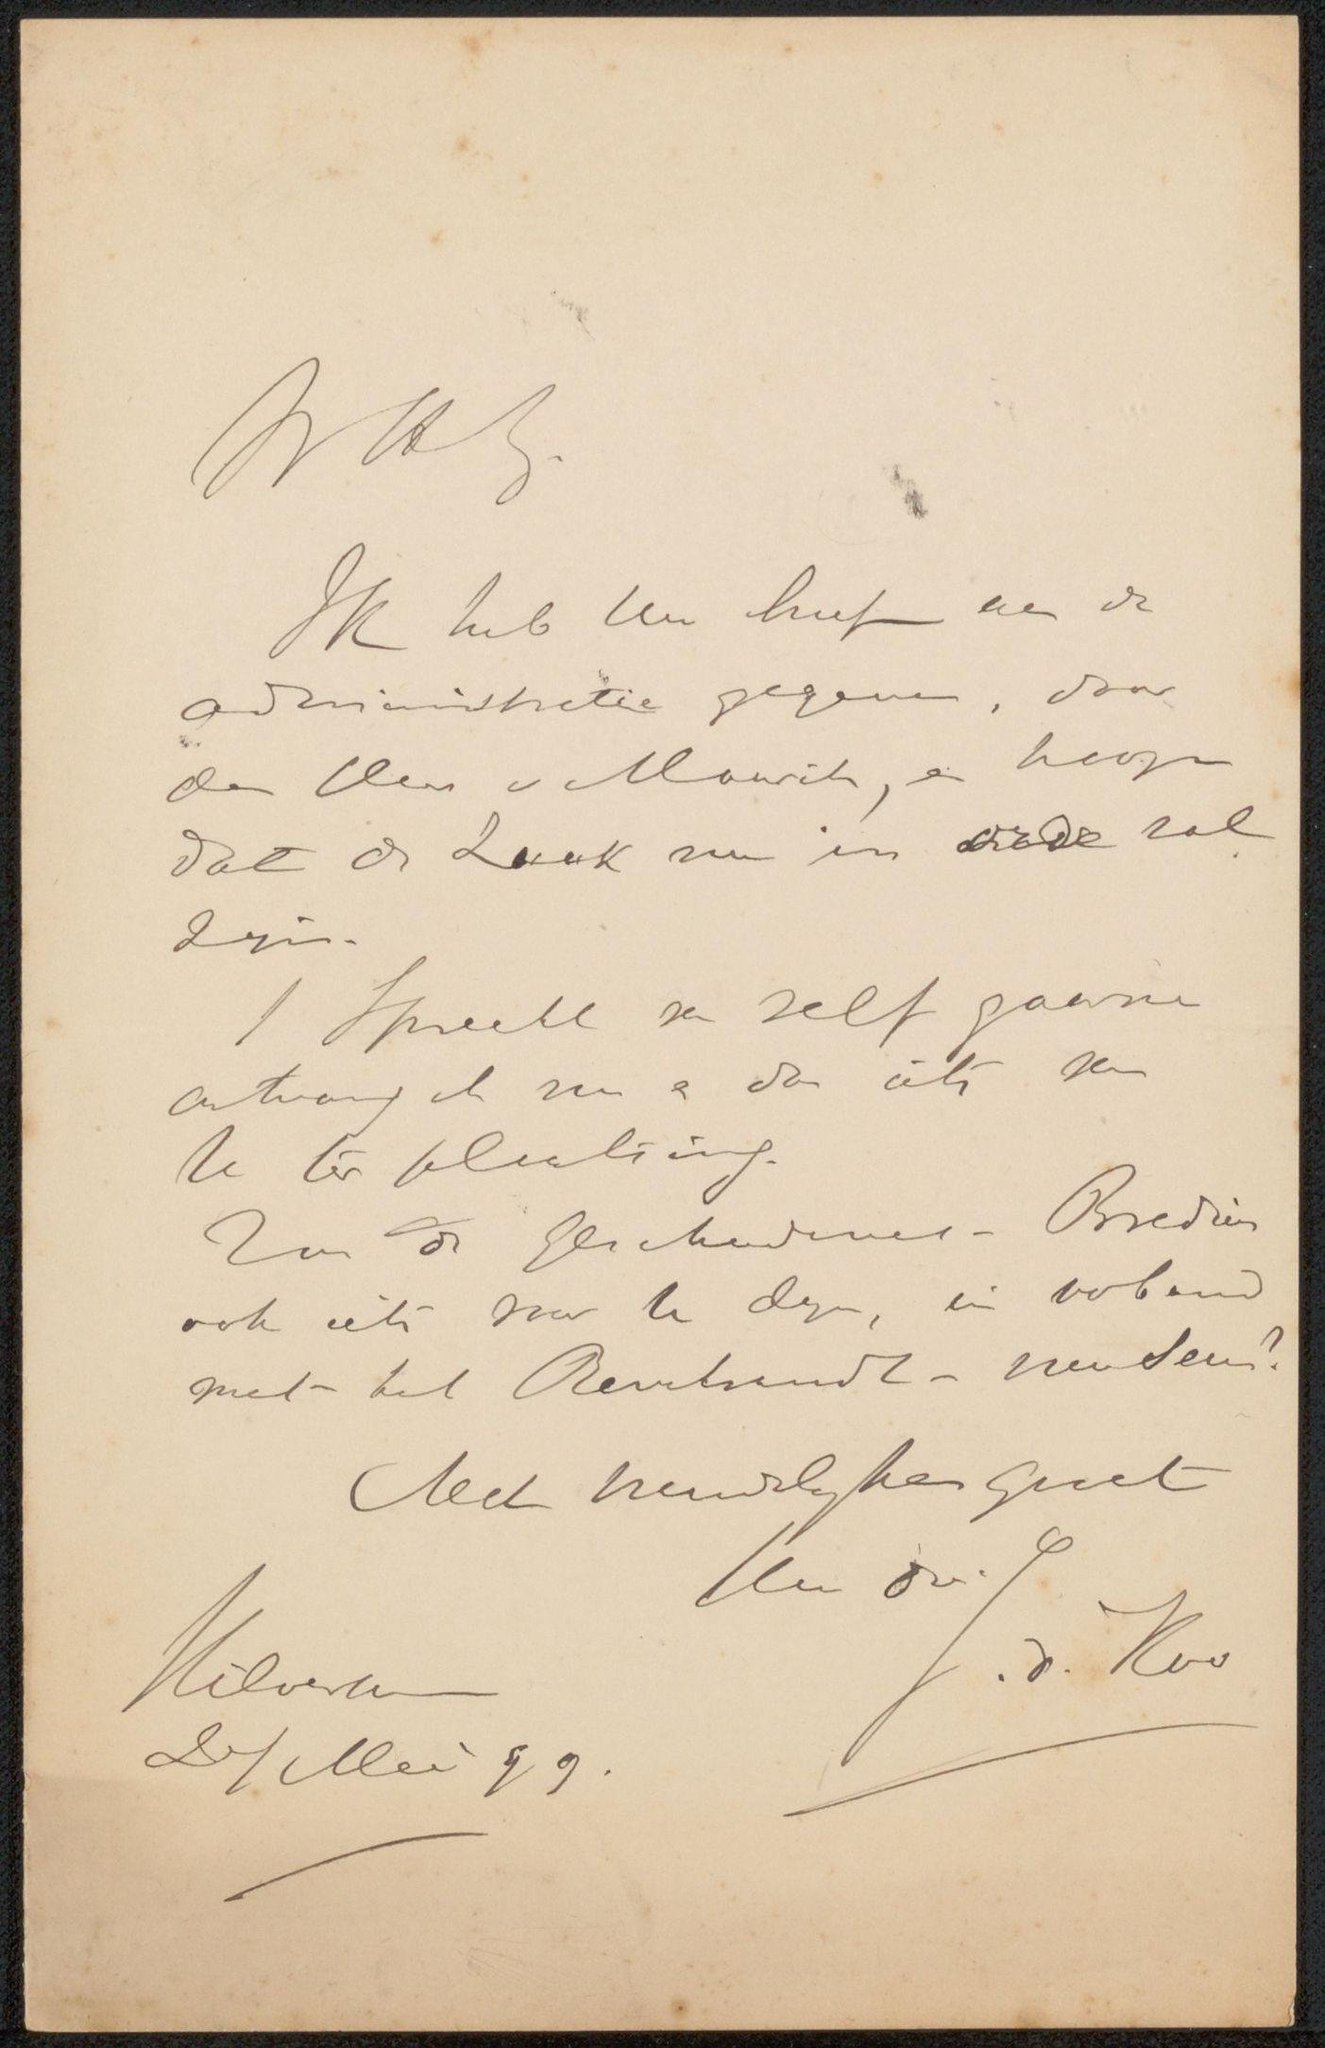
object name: letter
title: Brief aan Philip Zilcken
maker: johannes de koo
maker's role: auteur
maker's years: 1841-1909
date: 1899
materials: ink, paper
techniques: pen, writing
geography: hilversum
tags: abraham bredius, amsterdam, justus van maurik jr., the hague, draughtsman, philip zilcken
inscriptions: collector's mark: ‘RPK’